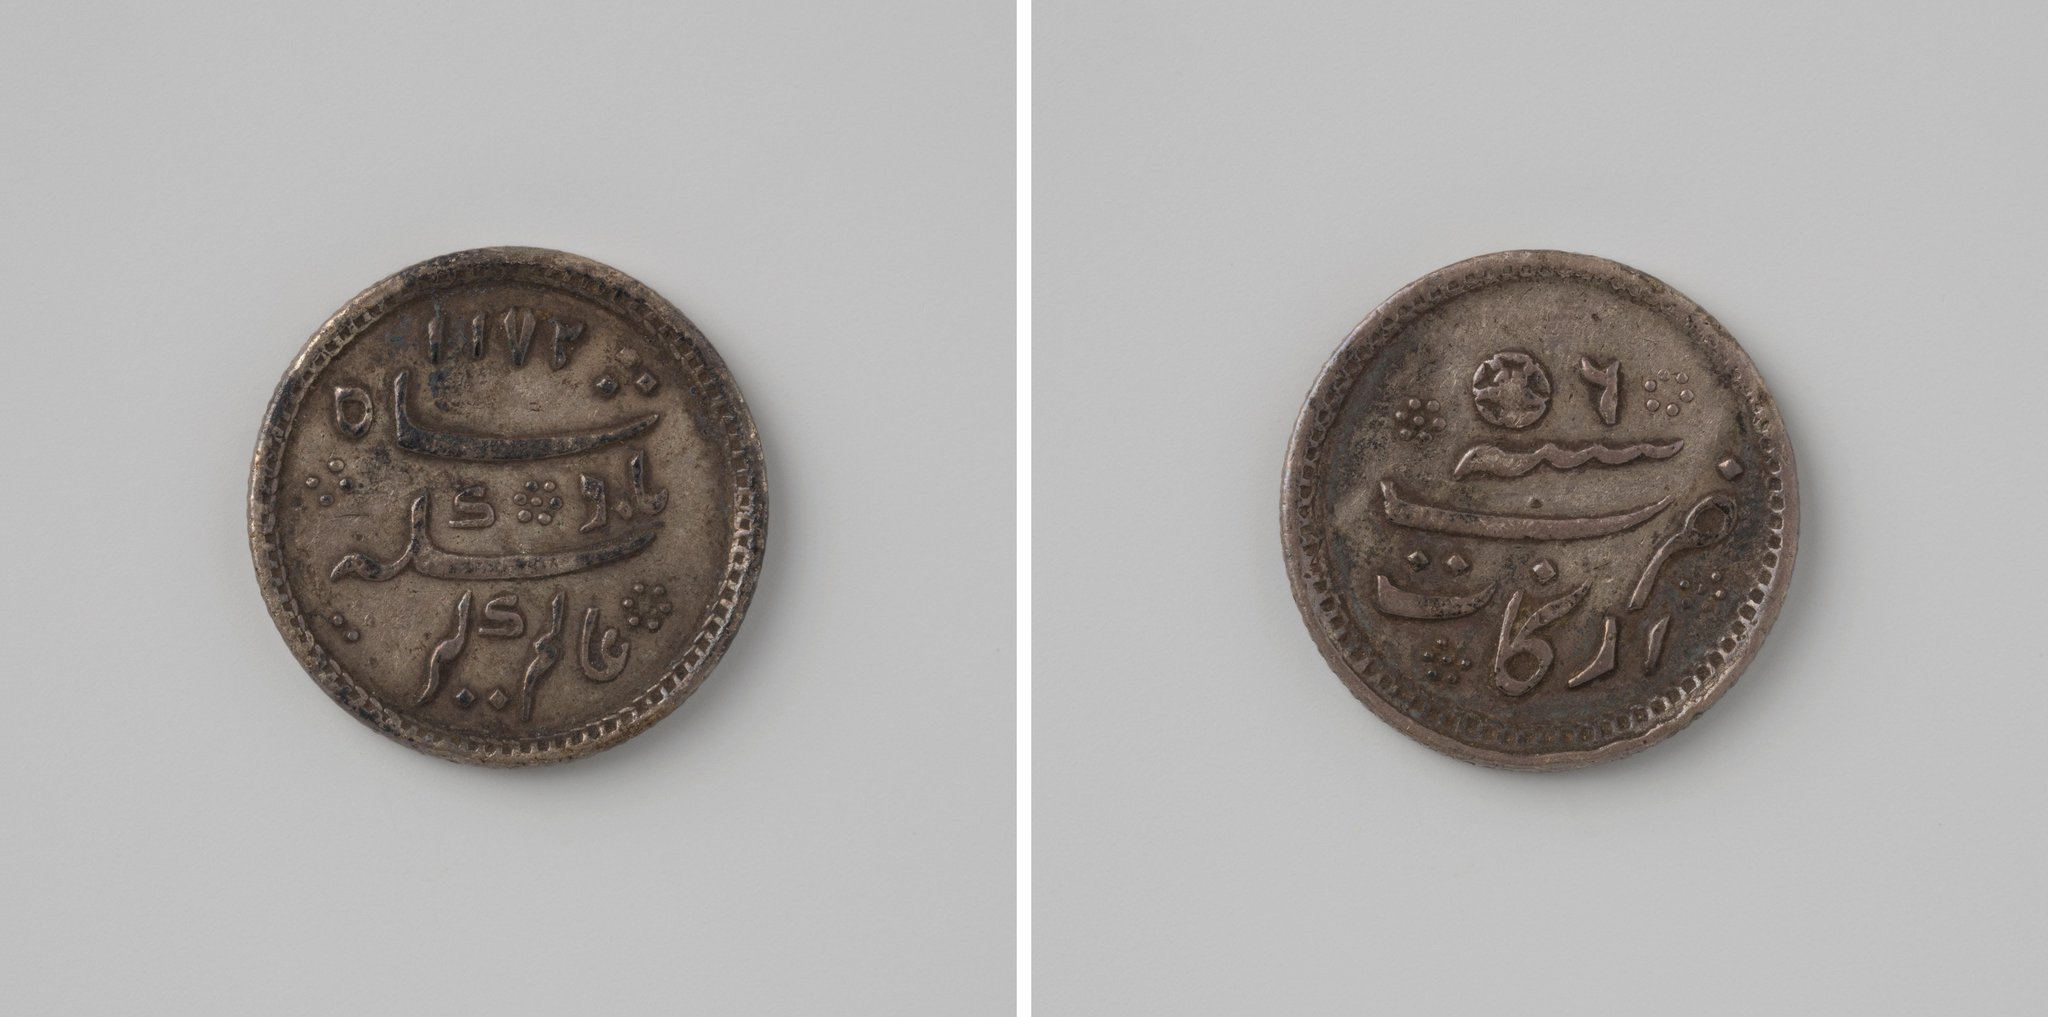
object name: coin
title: 1/4 arkot-roepie voor Madras in India van de Engelse Oostindische Compagnie (EIC) op naam van sjah Alamgir II,1172 [=1759]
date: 1823-1825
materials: silver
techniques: striking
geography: kolkata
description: Zilveren munt. Voorzijde: in Arabische lettertekens in drie regels opschrift met bovenaan aanduiding jaartal: 1172. Keerzijde: in Arabische lettertekens in twee regels opschrift. Bovenaan regeringsjaaar: 6 met links daarvan rozet [=muntplaats Calcutta]. Geslagen in de jaren 1823-1825 te Calcutta. Kartelrand.